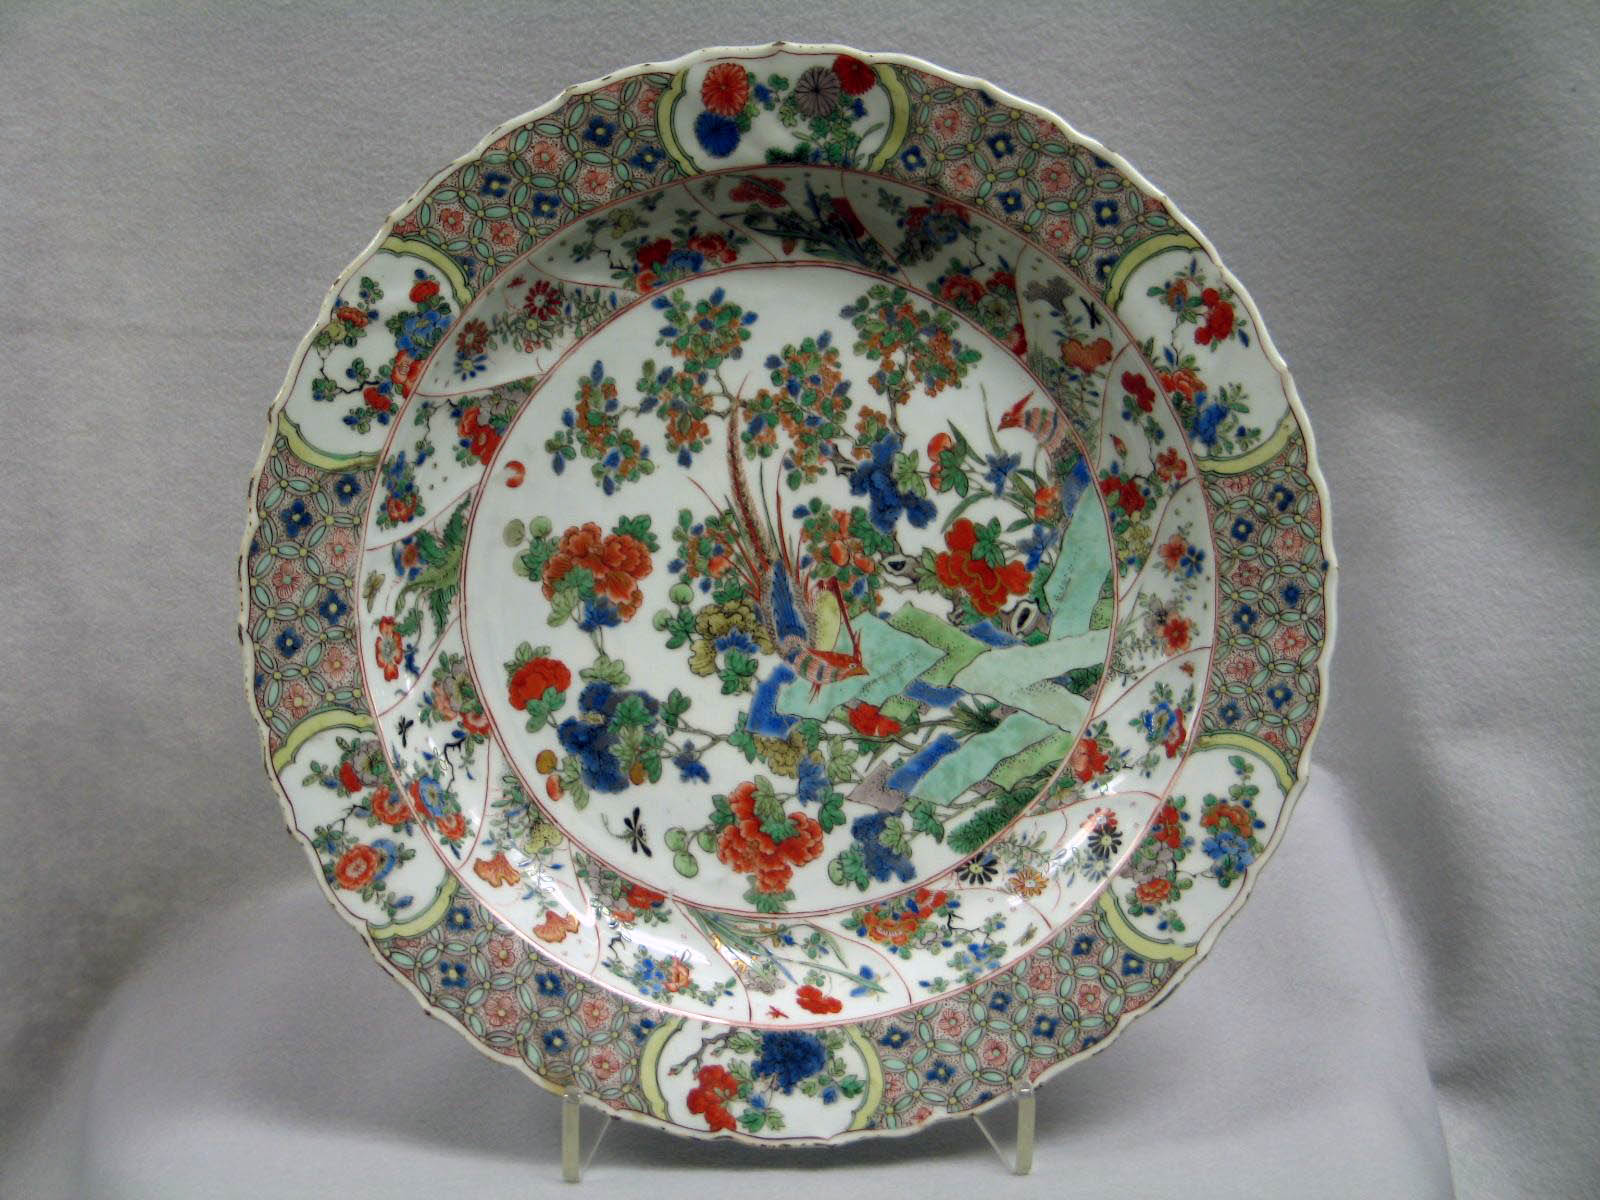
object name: dish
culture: chinese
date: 1680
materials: enamel, porcelain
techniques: overglaze, painting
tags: birds,flowers,leaves